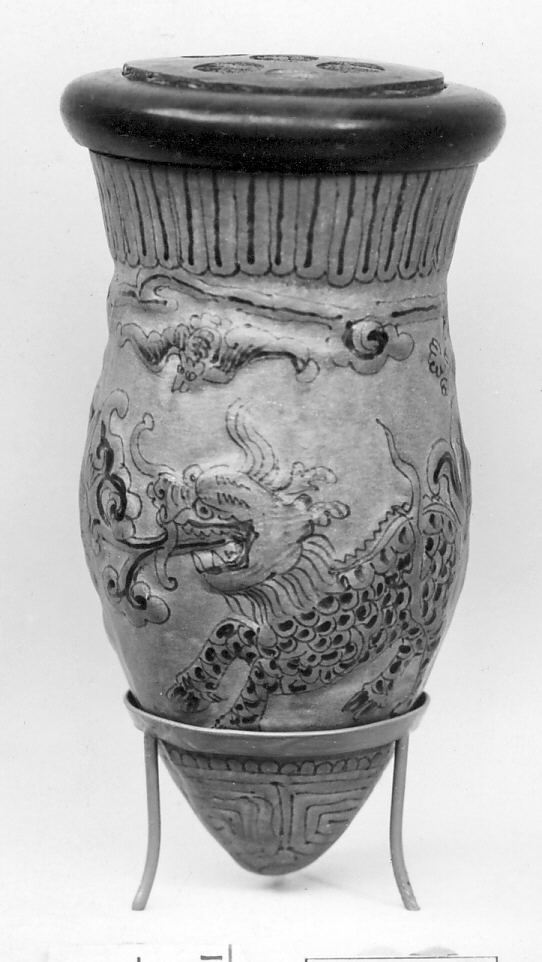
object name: cricket cage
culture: chinese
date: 1701-1900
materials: wood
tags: mythical creatures